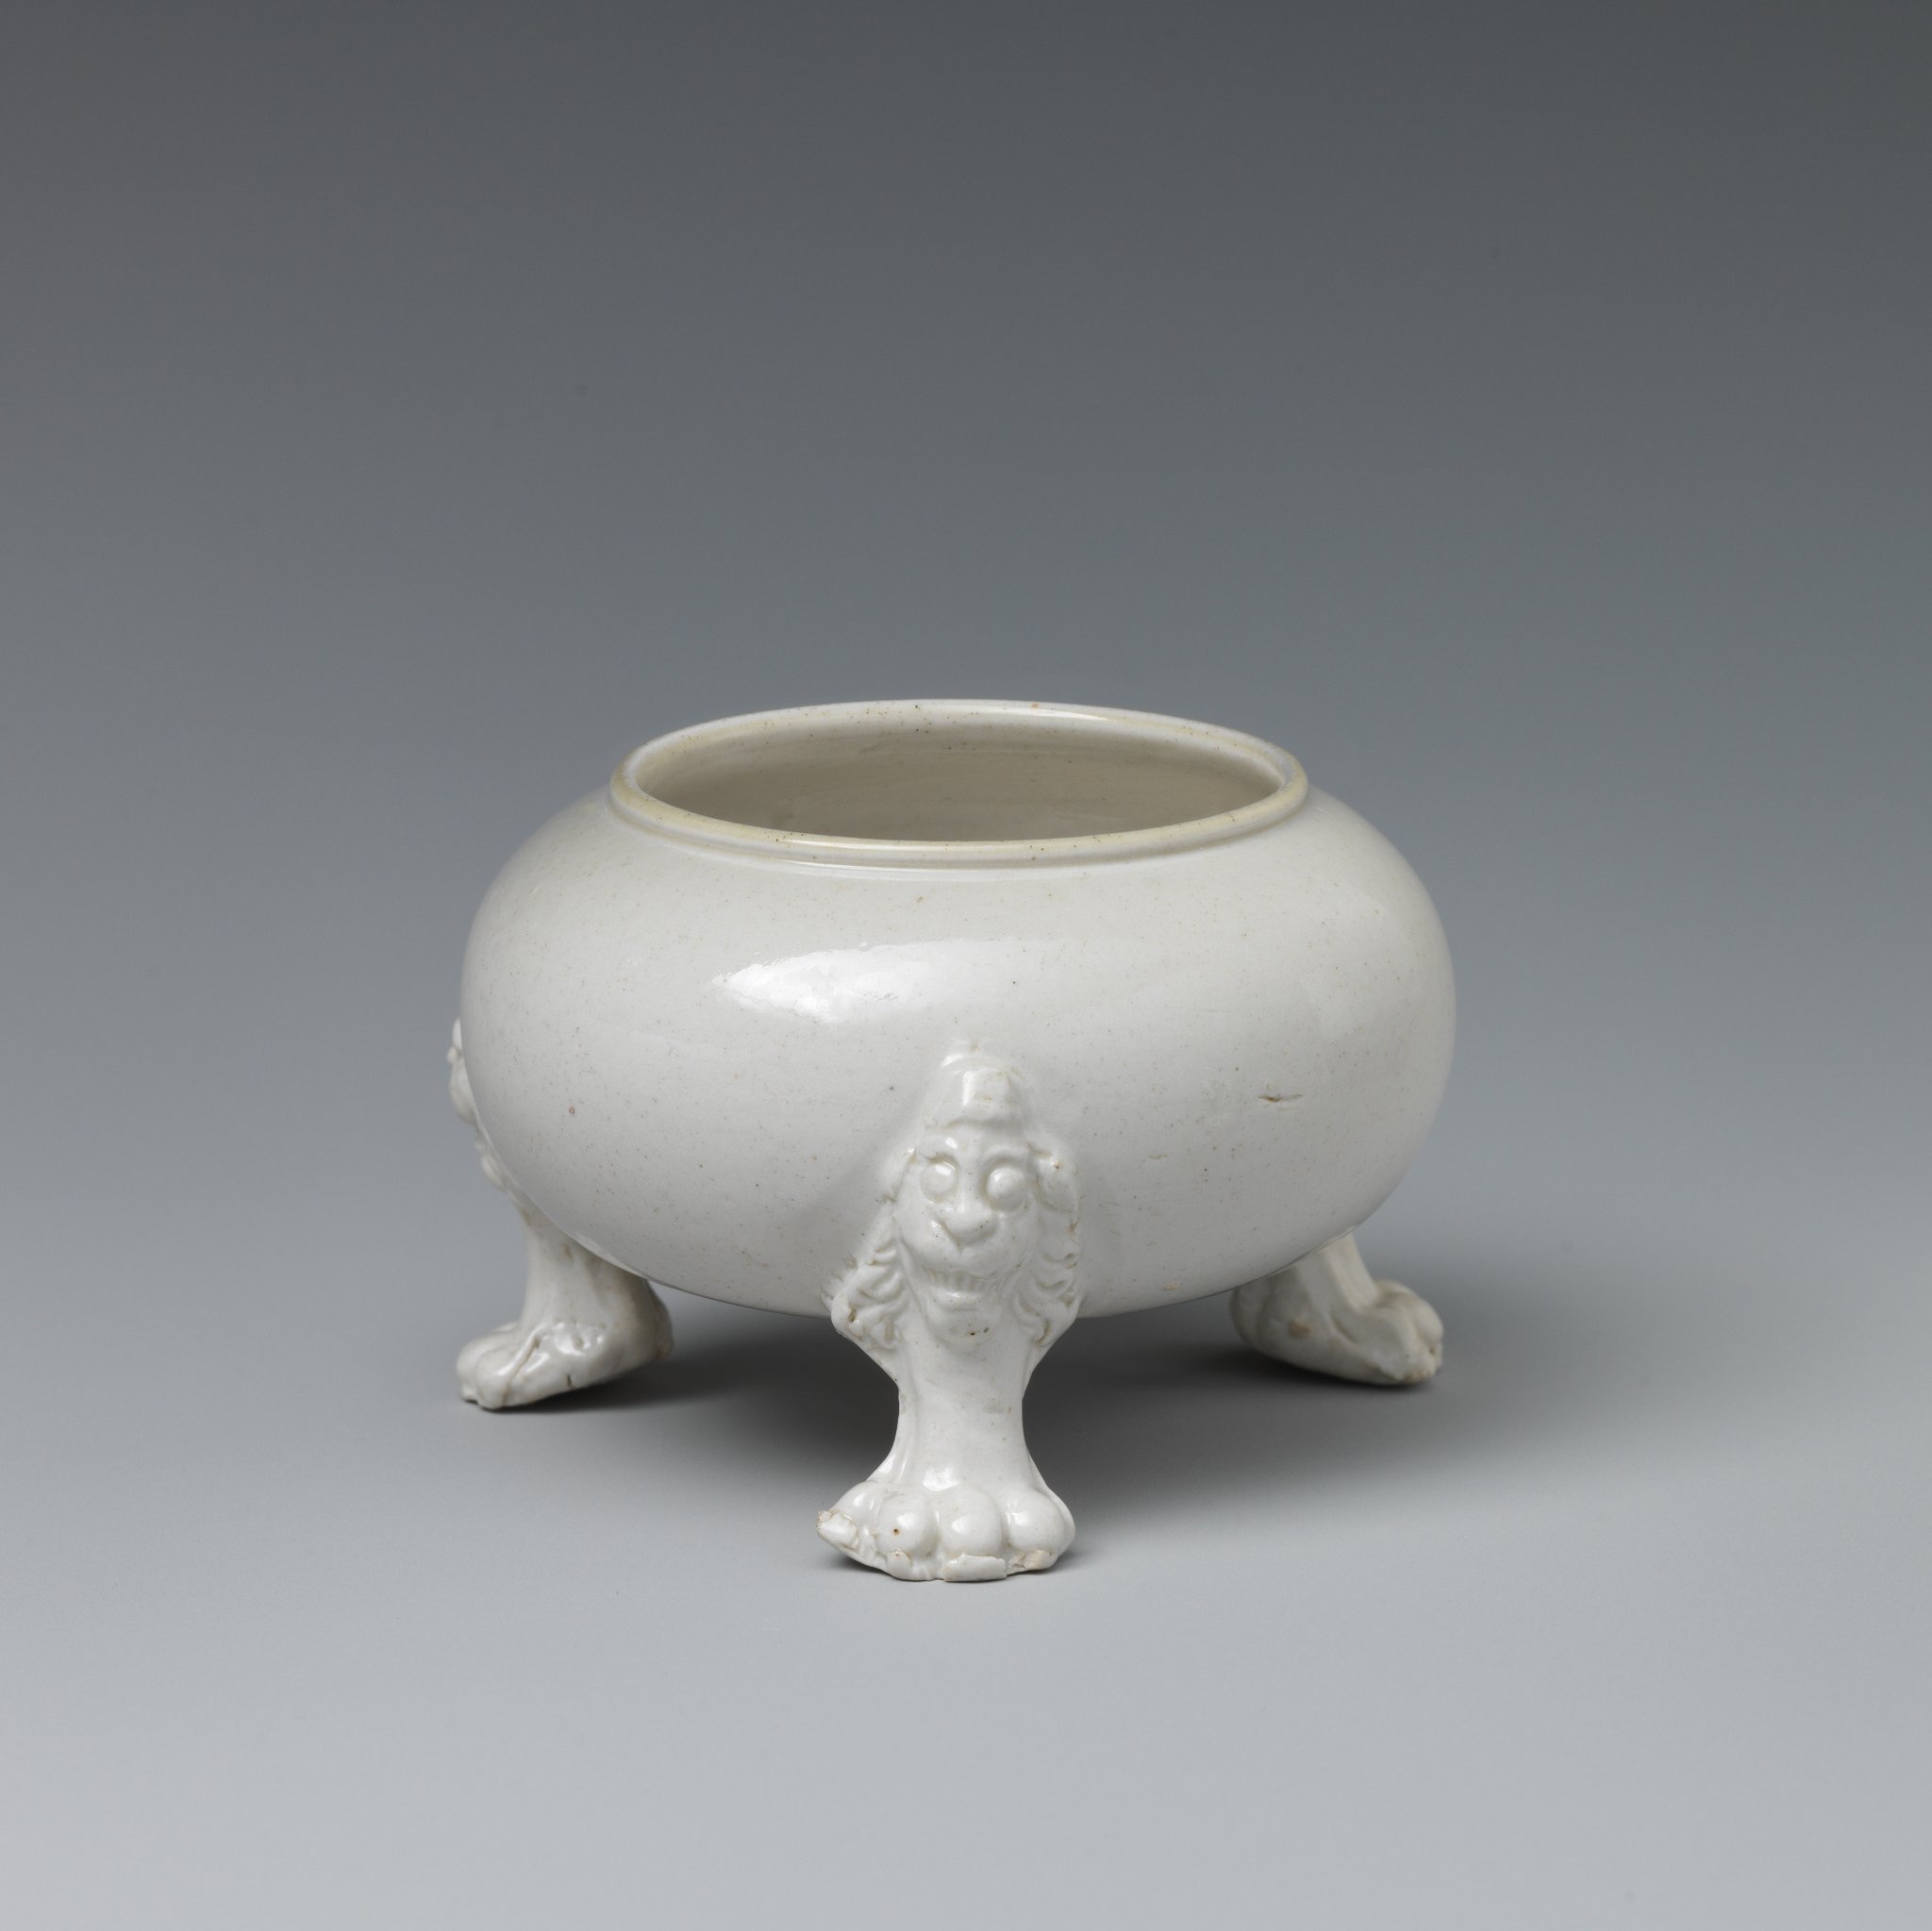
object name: saltcellar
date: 1750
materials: stoneware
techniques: salt glaze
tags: lions